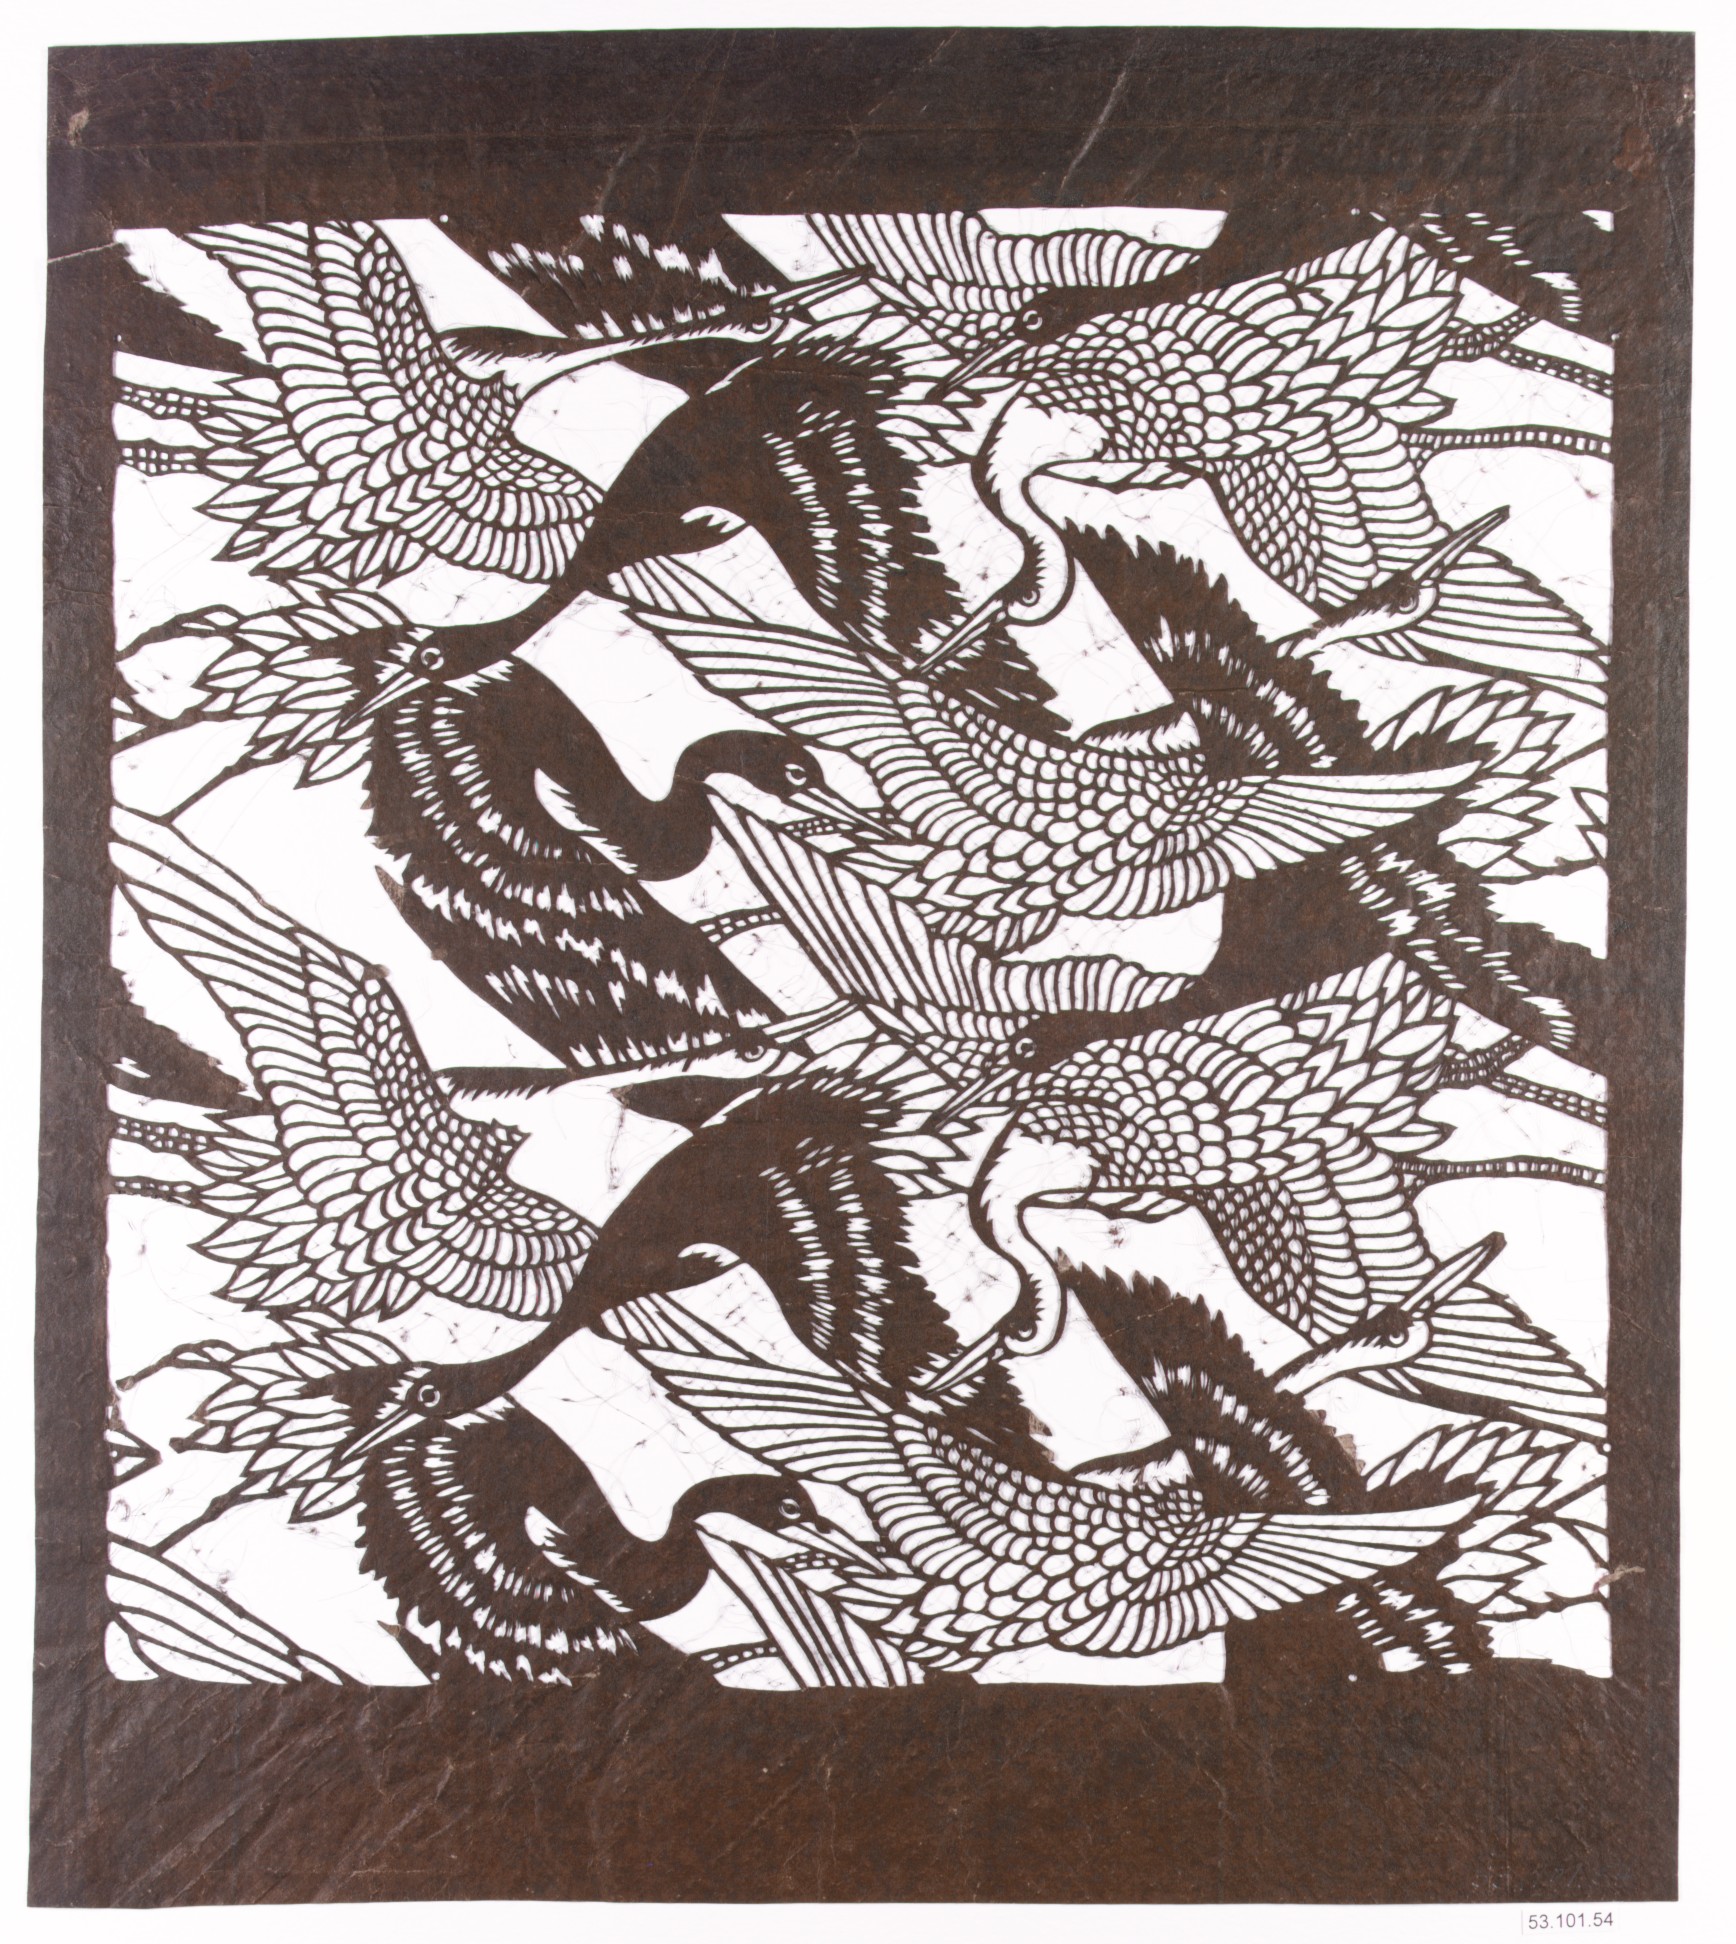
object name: stencil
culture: japanese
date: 1615-1868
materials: paper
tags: birds